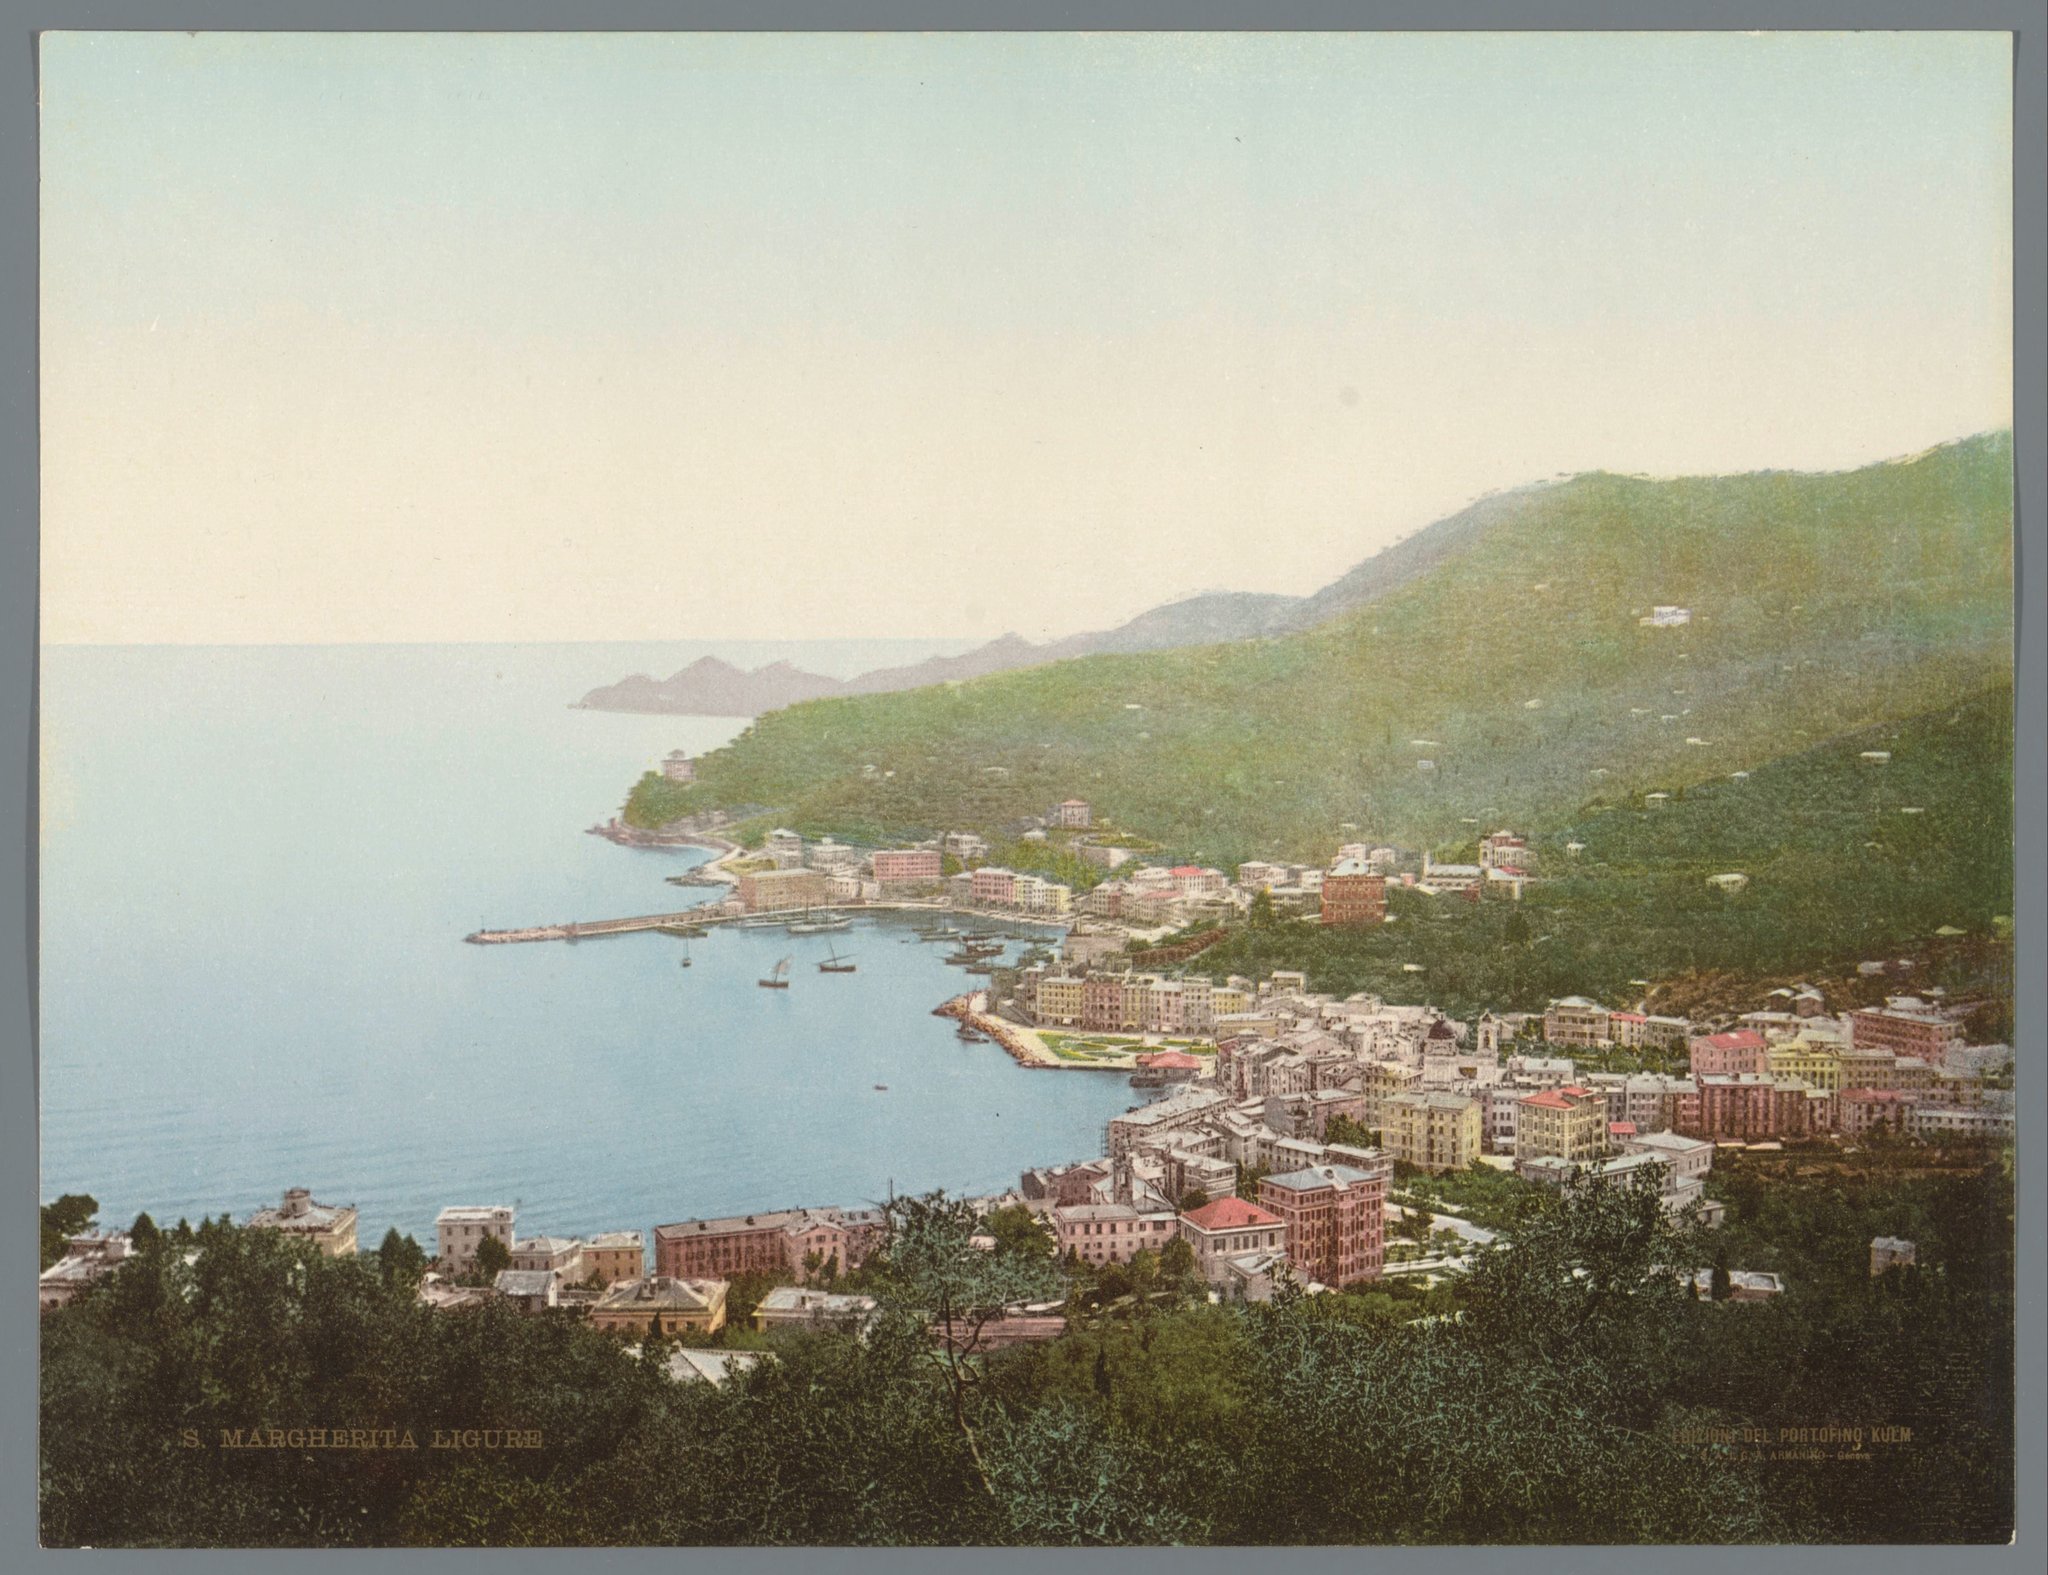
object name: photomechanical print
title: S. Margherita Ligure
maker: Anonymous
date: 1880-1917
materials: paper, photographic process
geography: santa margherita ligure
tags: gulf, bay, prospect of city, town panorama, silhouette of city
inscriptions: inscription: ‘EDIZIONI DEL PORTOFINO KULM/ S.A.I.G.A. ARMANINO - Genova’